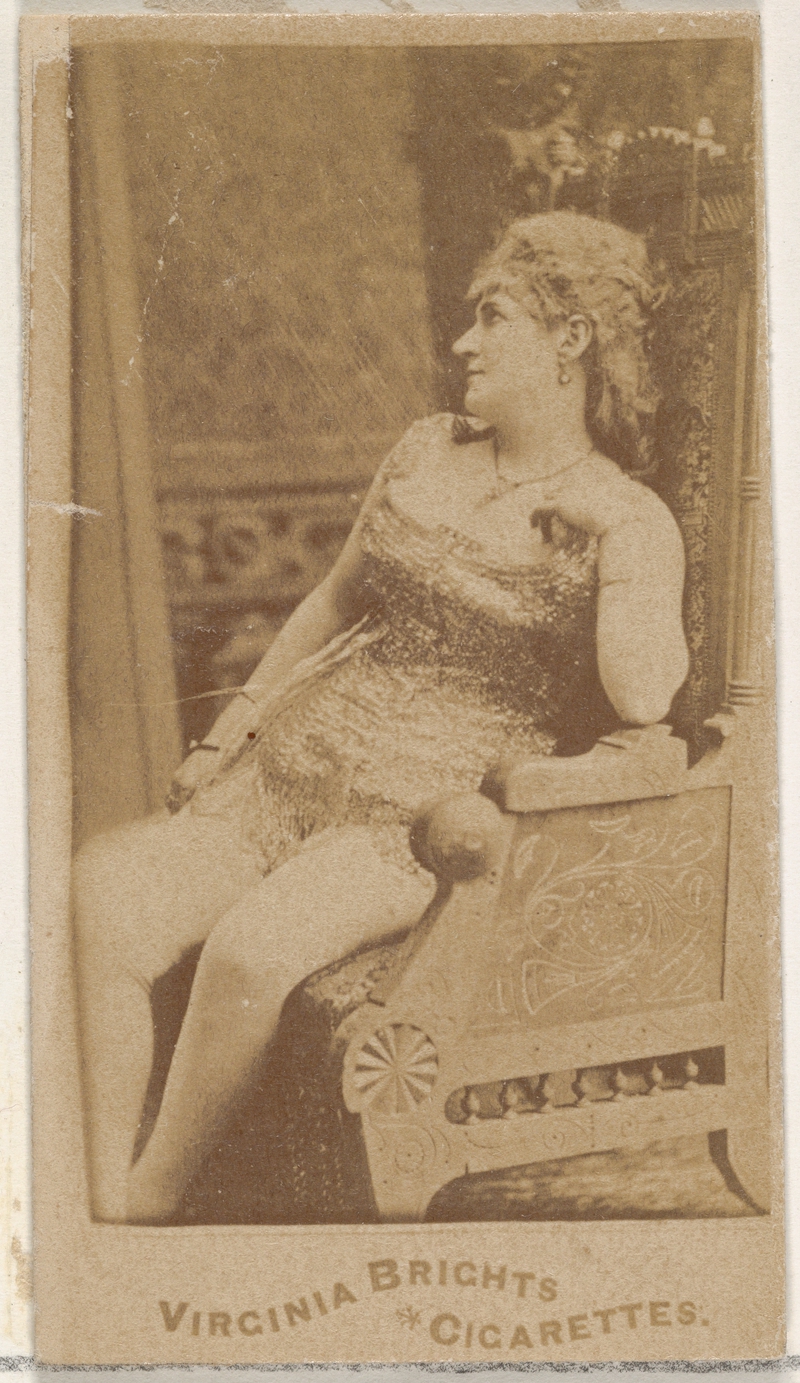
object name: photograph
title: From the Actors and Actresses series (N45, Type 4) for Virginia Brights Cigarettes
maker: allen & ginter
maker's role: publisher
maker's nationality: american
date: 1888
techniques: albumen silver print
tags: women,actresses